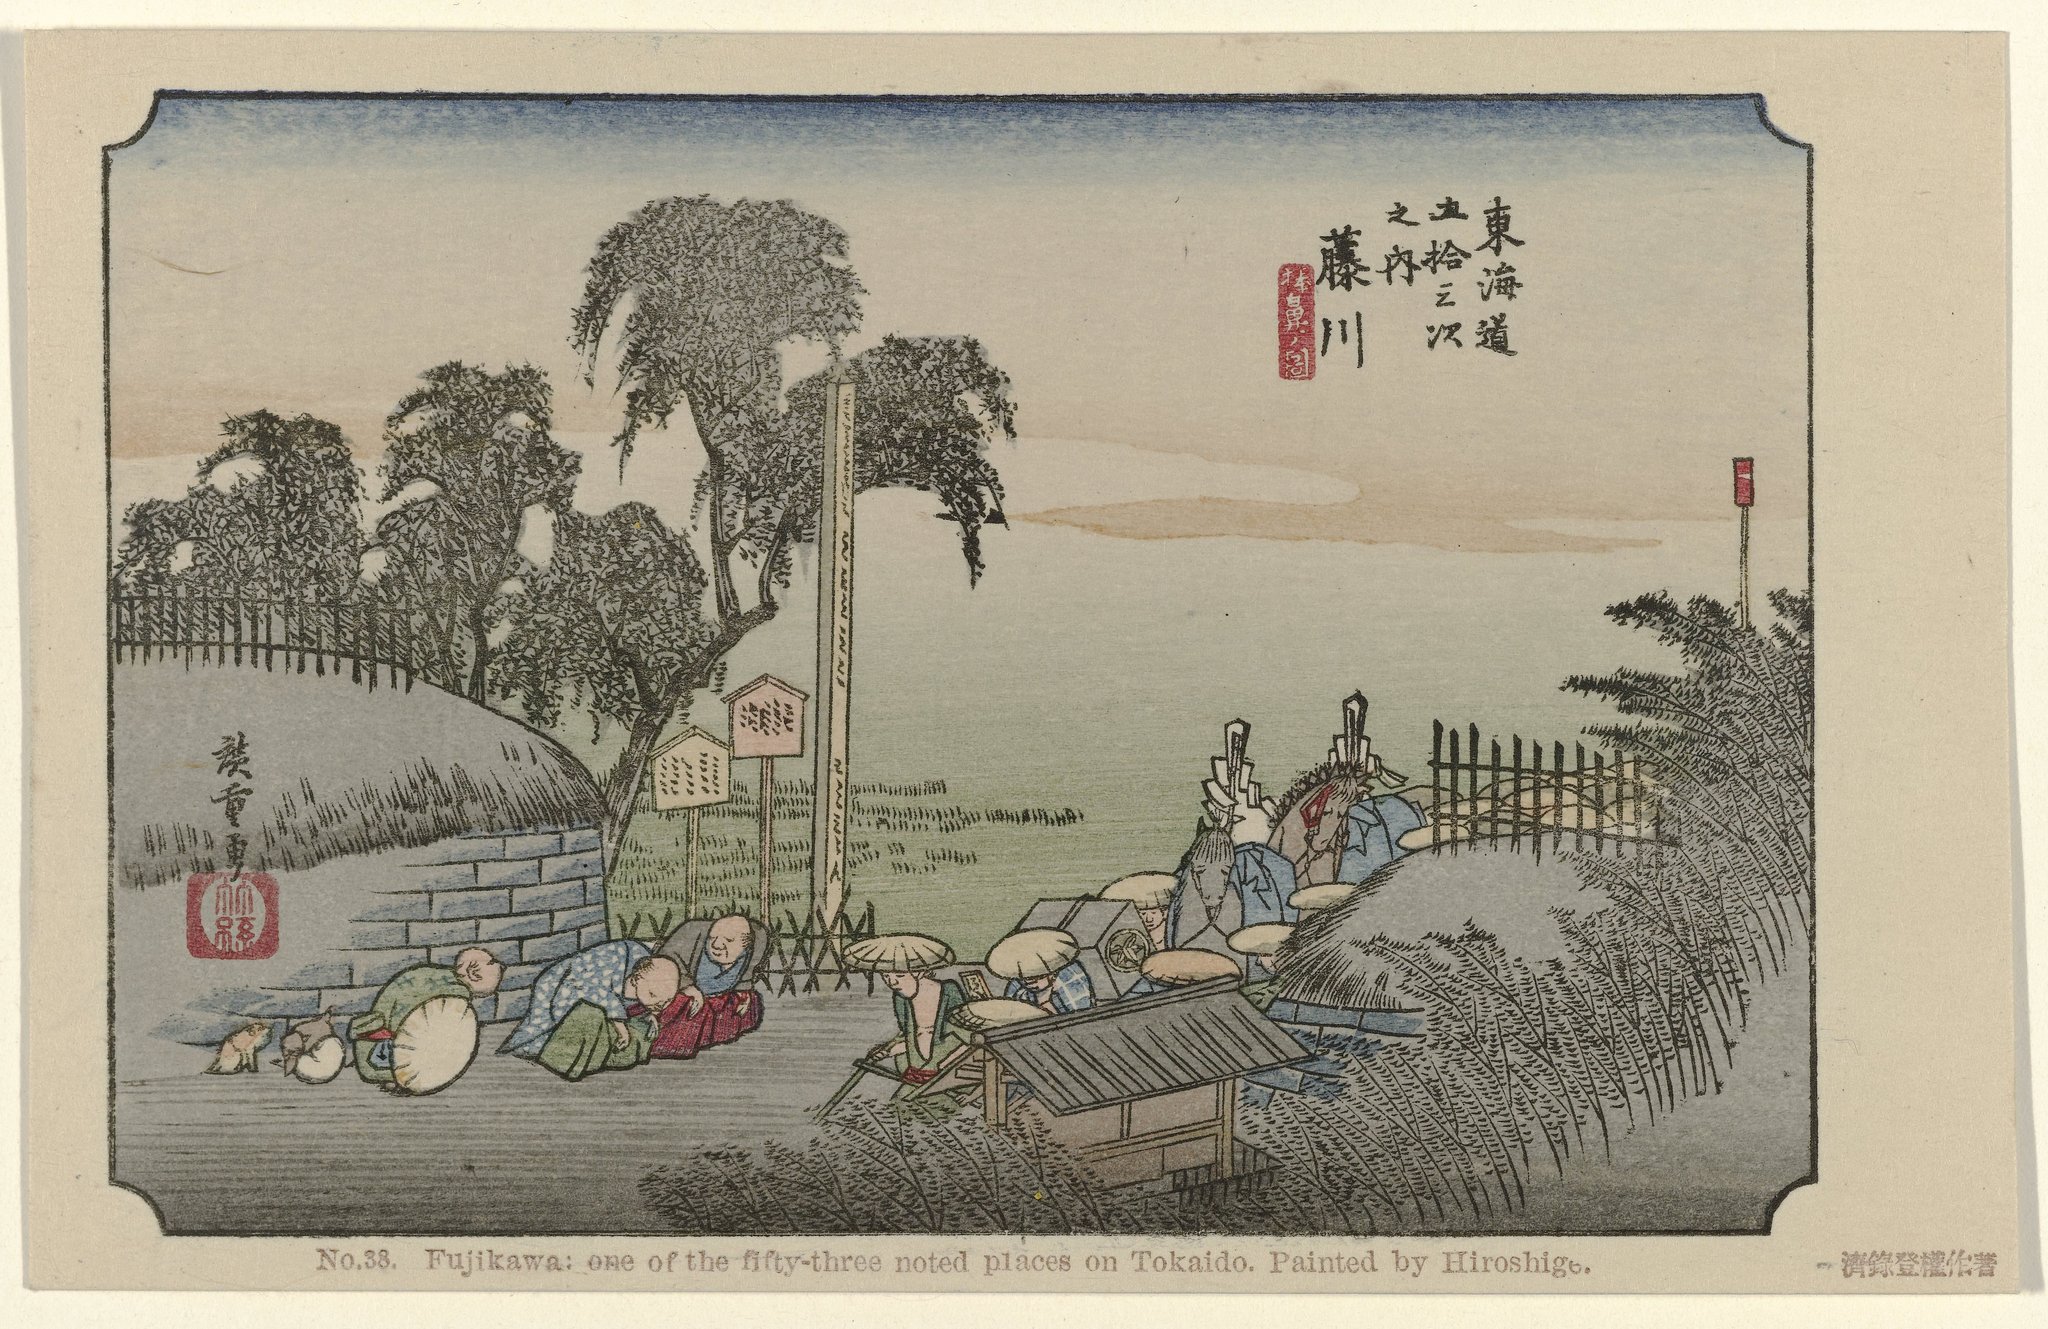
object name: ansichtkaart, prentbriefkaart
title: No. 38. Fujikawa: one of the fifty-three noted places on Tokaido, painted by Hiroshige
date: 1906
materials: cardboard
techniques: woodcut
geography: japan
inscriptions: date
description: Drie boeren knielen voor de processie van een krijgsheer (daimyo).